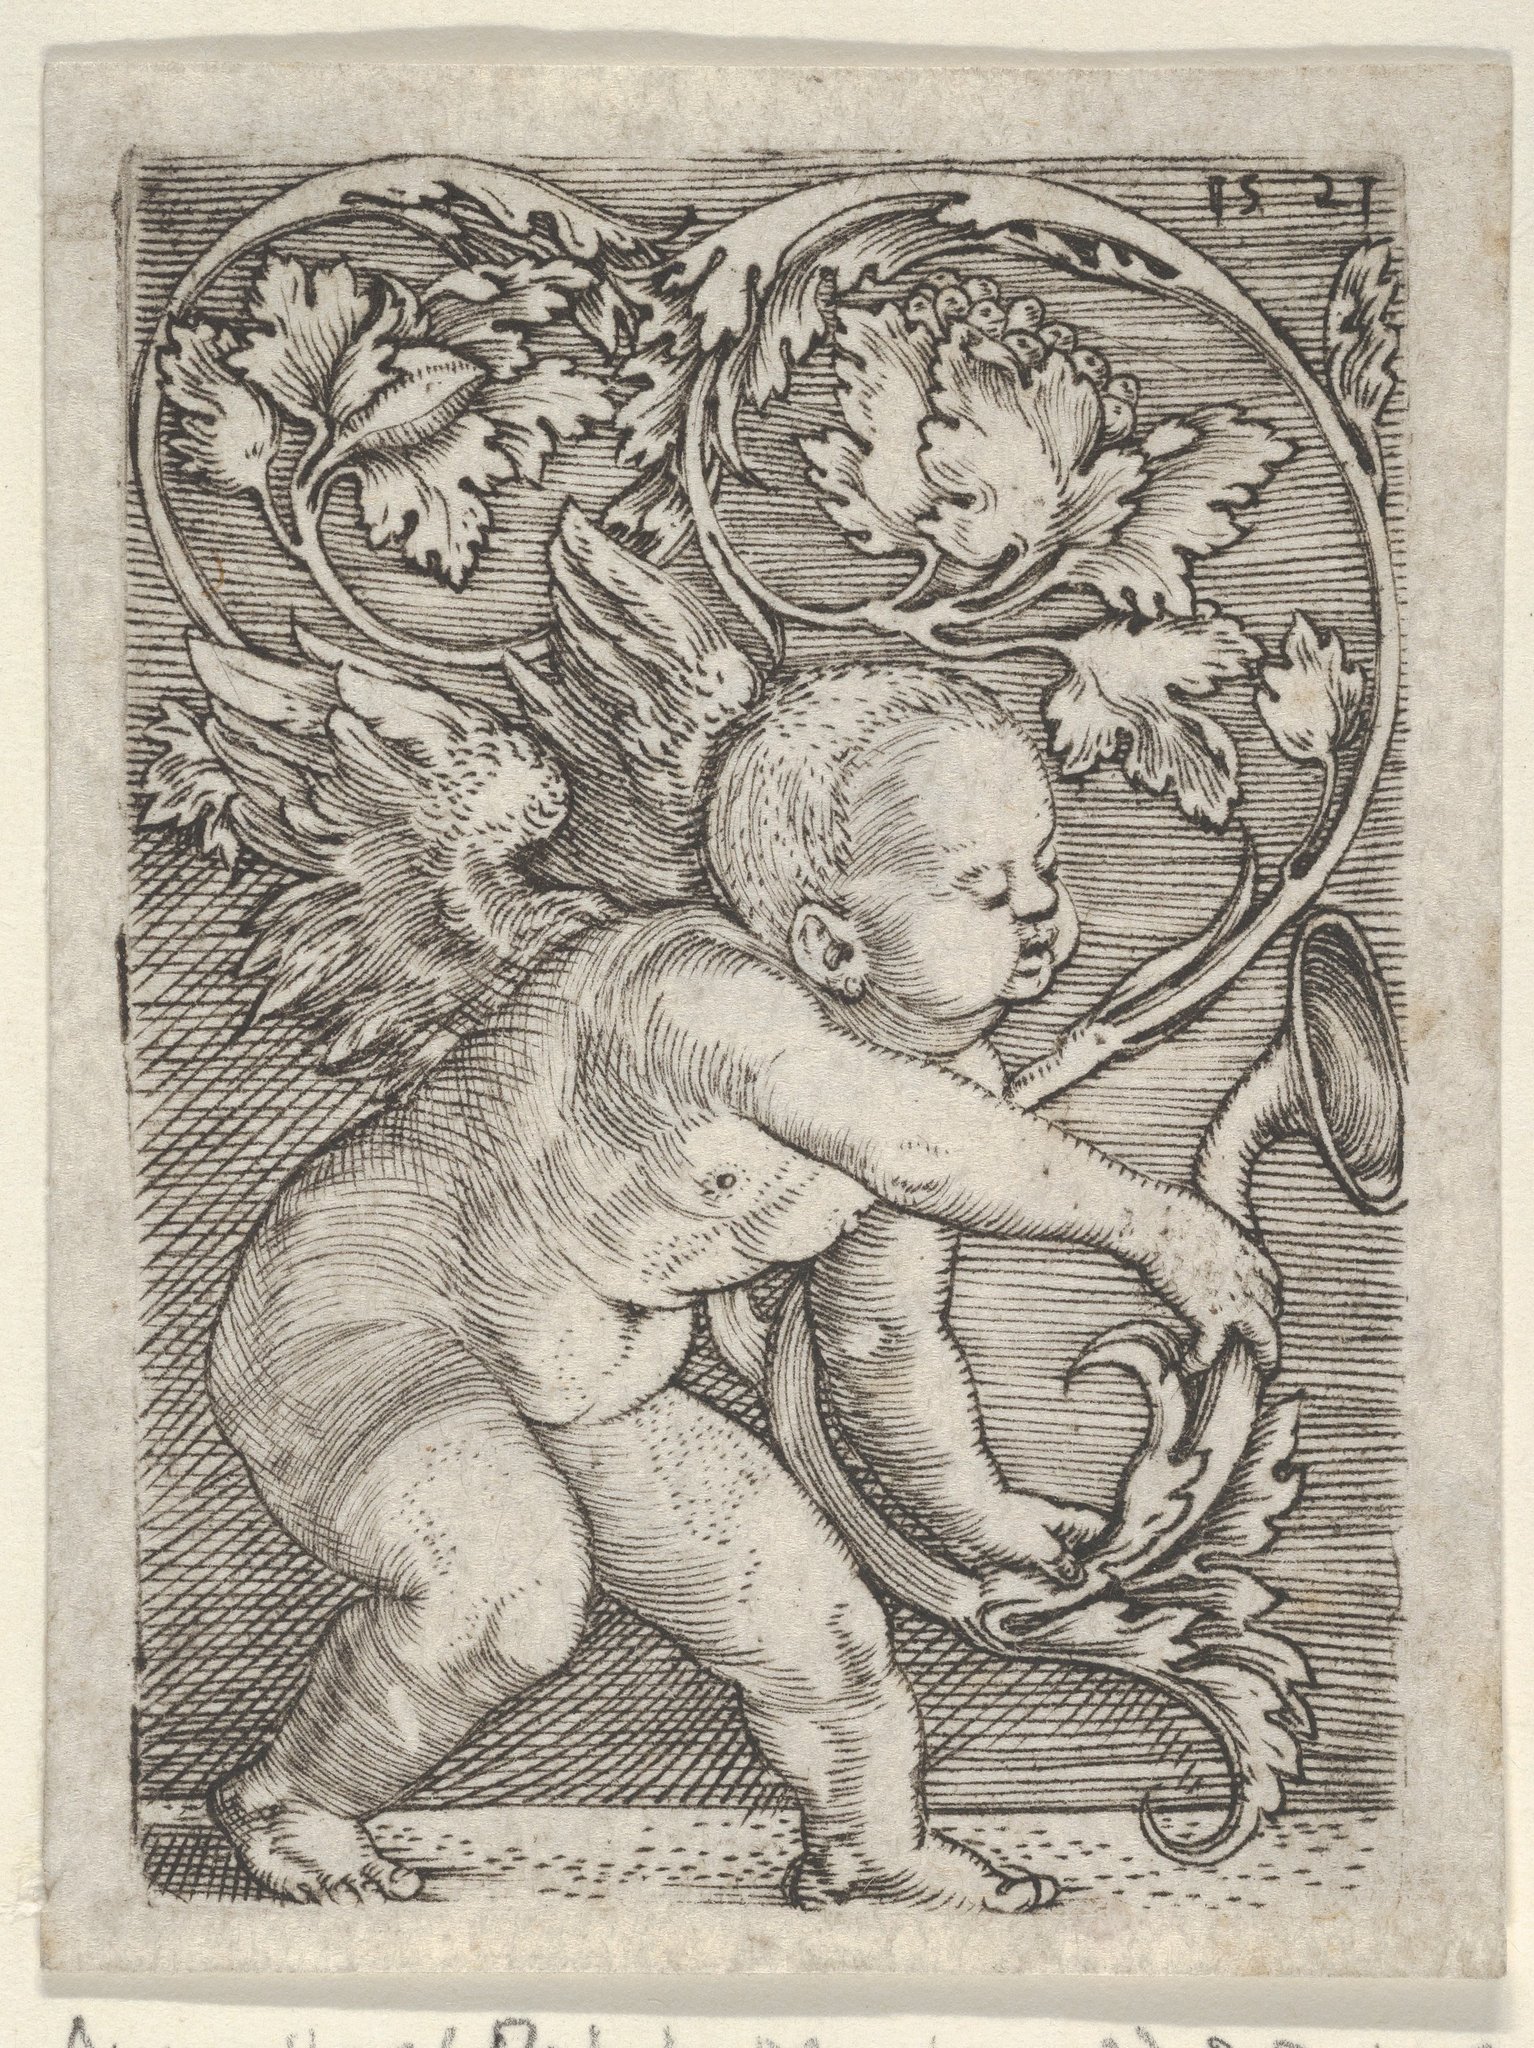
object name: print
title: Vertical Panel with Cupid Holding the End of a Plant Sprouting Tendrils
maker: jacob binck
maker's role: artist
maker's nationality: german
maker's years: 1494-1569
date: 1521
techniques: engraving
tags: cupid,leaves